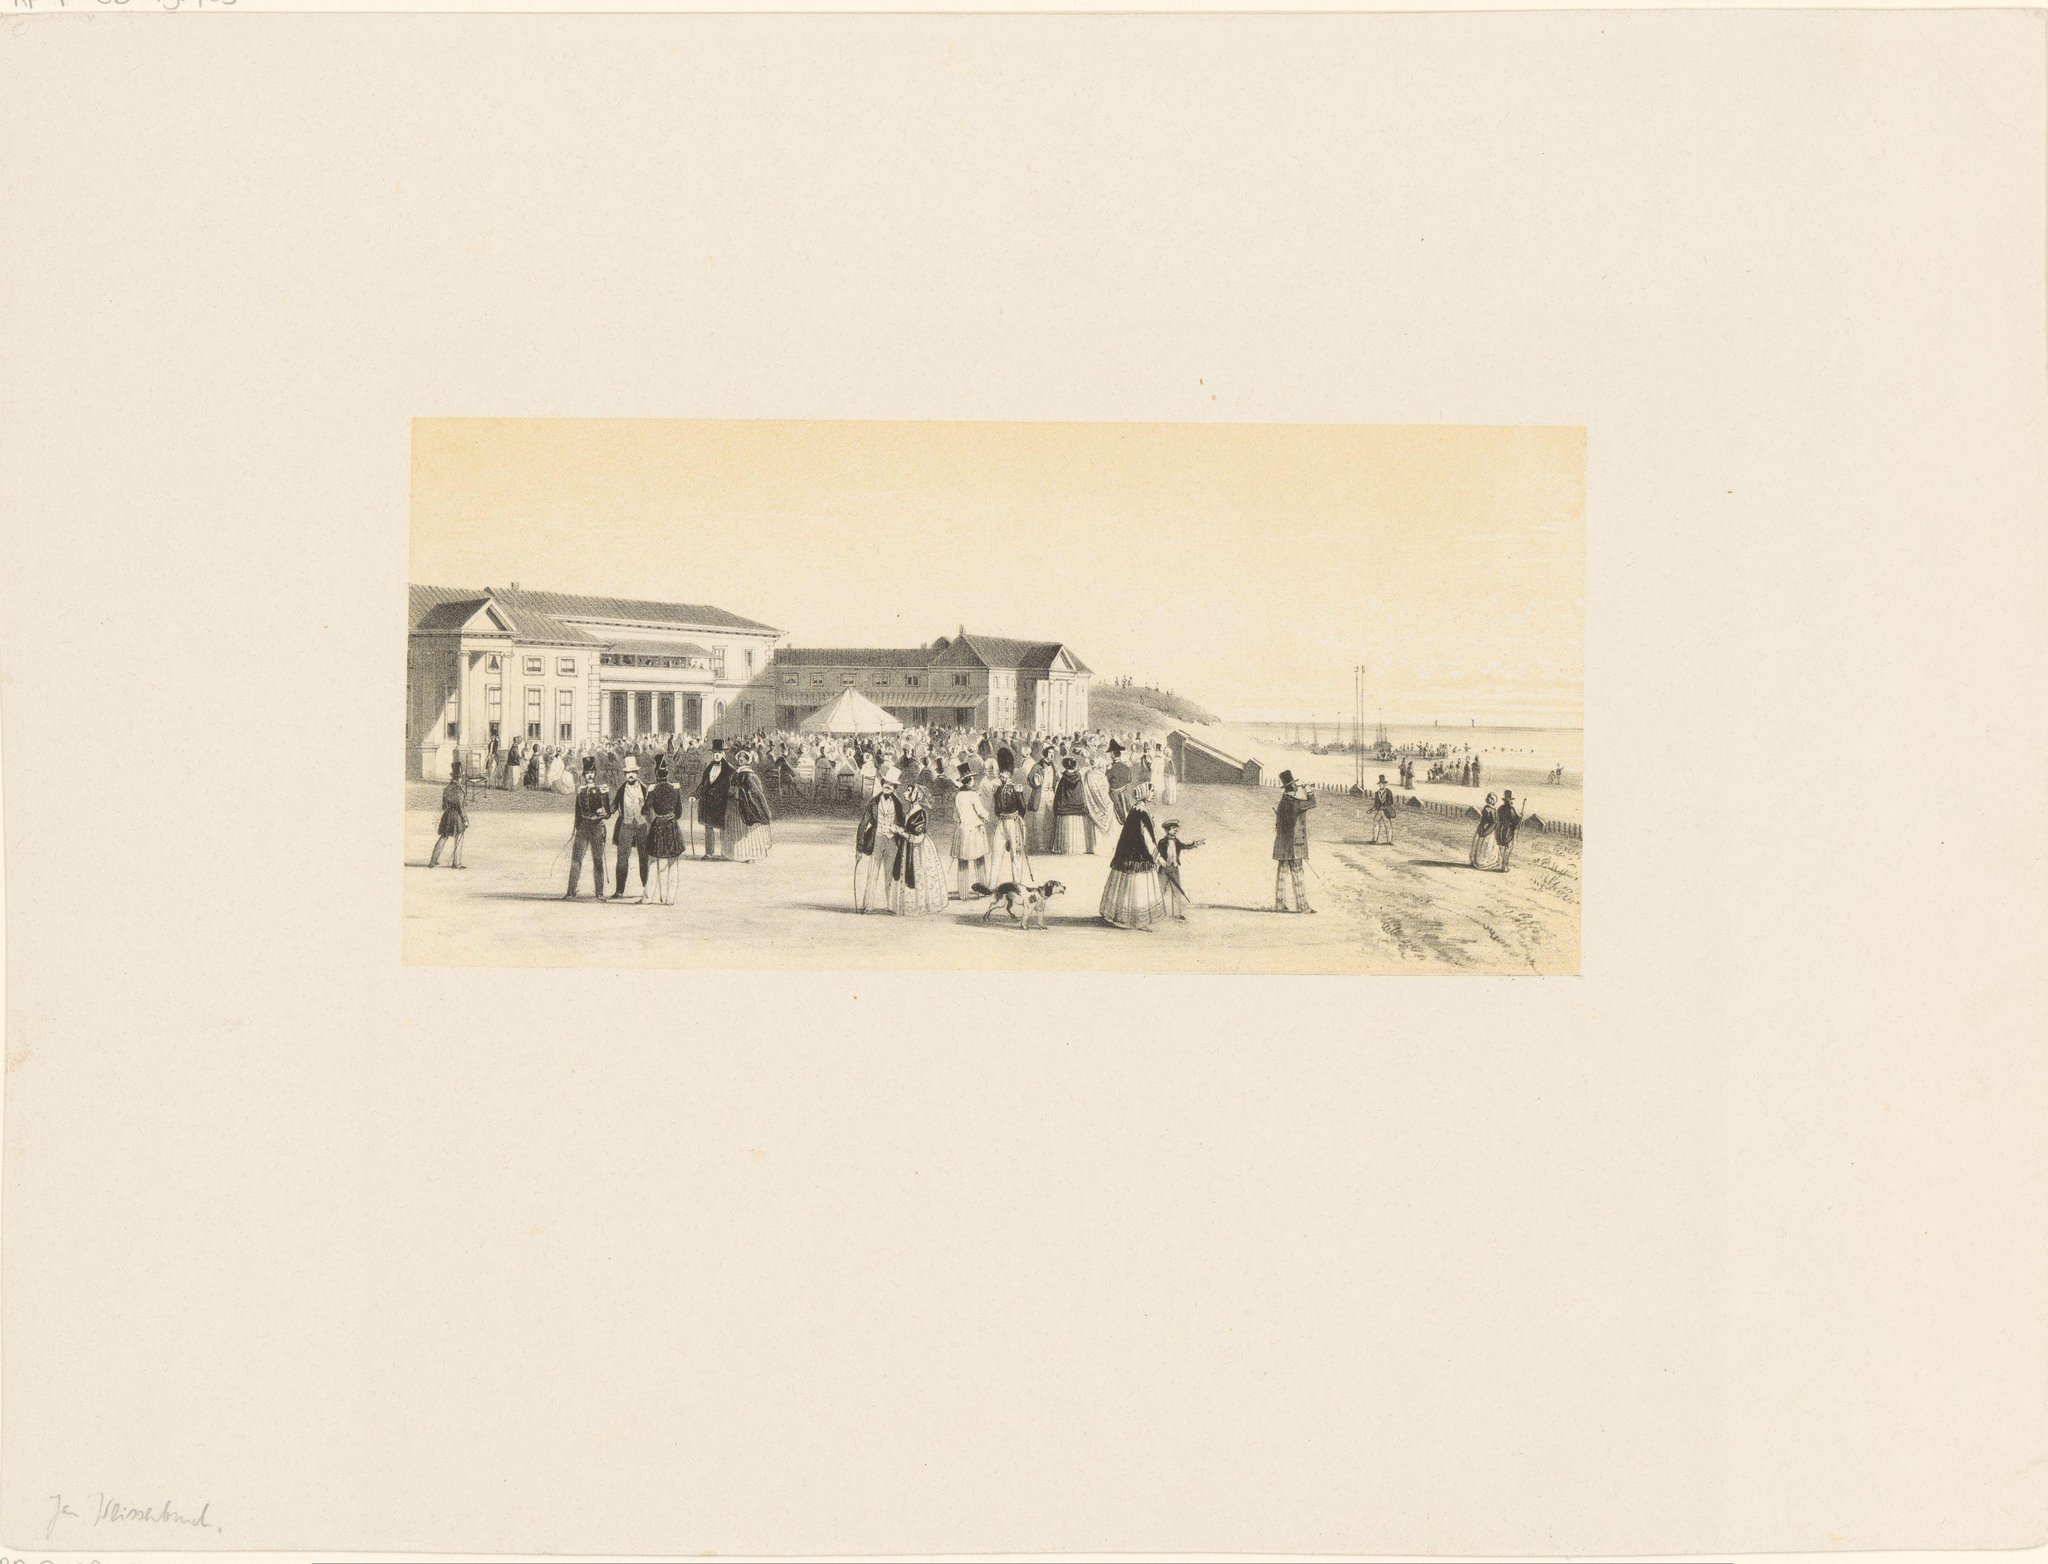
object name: print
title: Mensen bij het strand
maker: jan weissenbruch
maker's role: painter, print maker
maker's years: 1822-1880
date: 1832-1880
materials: paper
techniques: tone lithography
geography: the hague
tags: pavement, terrace in front of inn or restaurant, beach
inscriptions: collector's mark: Lugt 2228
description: Een groep recreërende mensen bij het strand. Links zitten mensen buiten op een terras. In de achtergrond liggen boten op het strand.